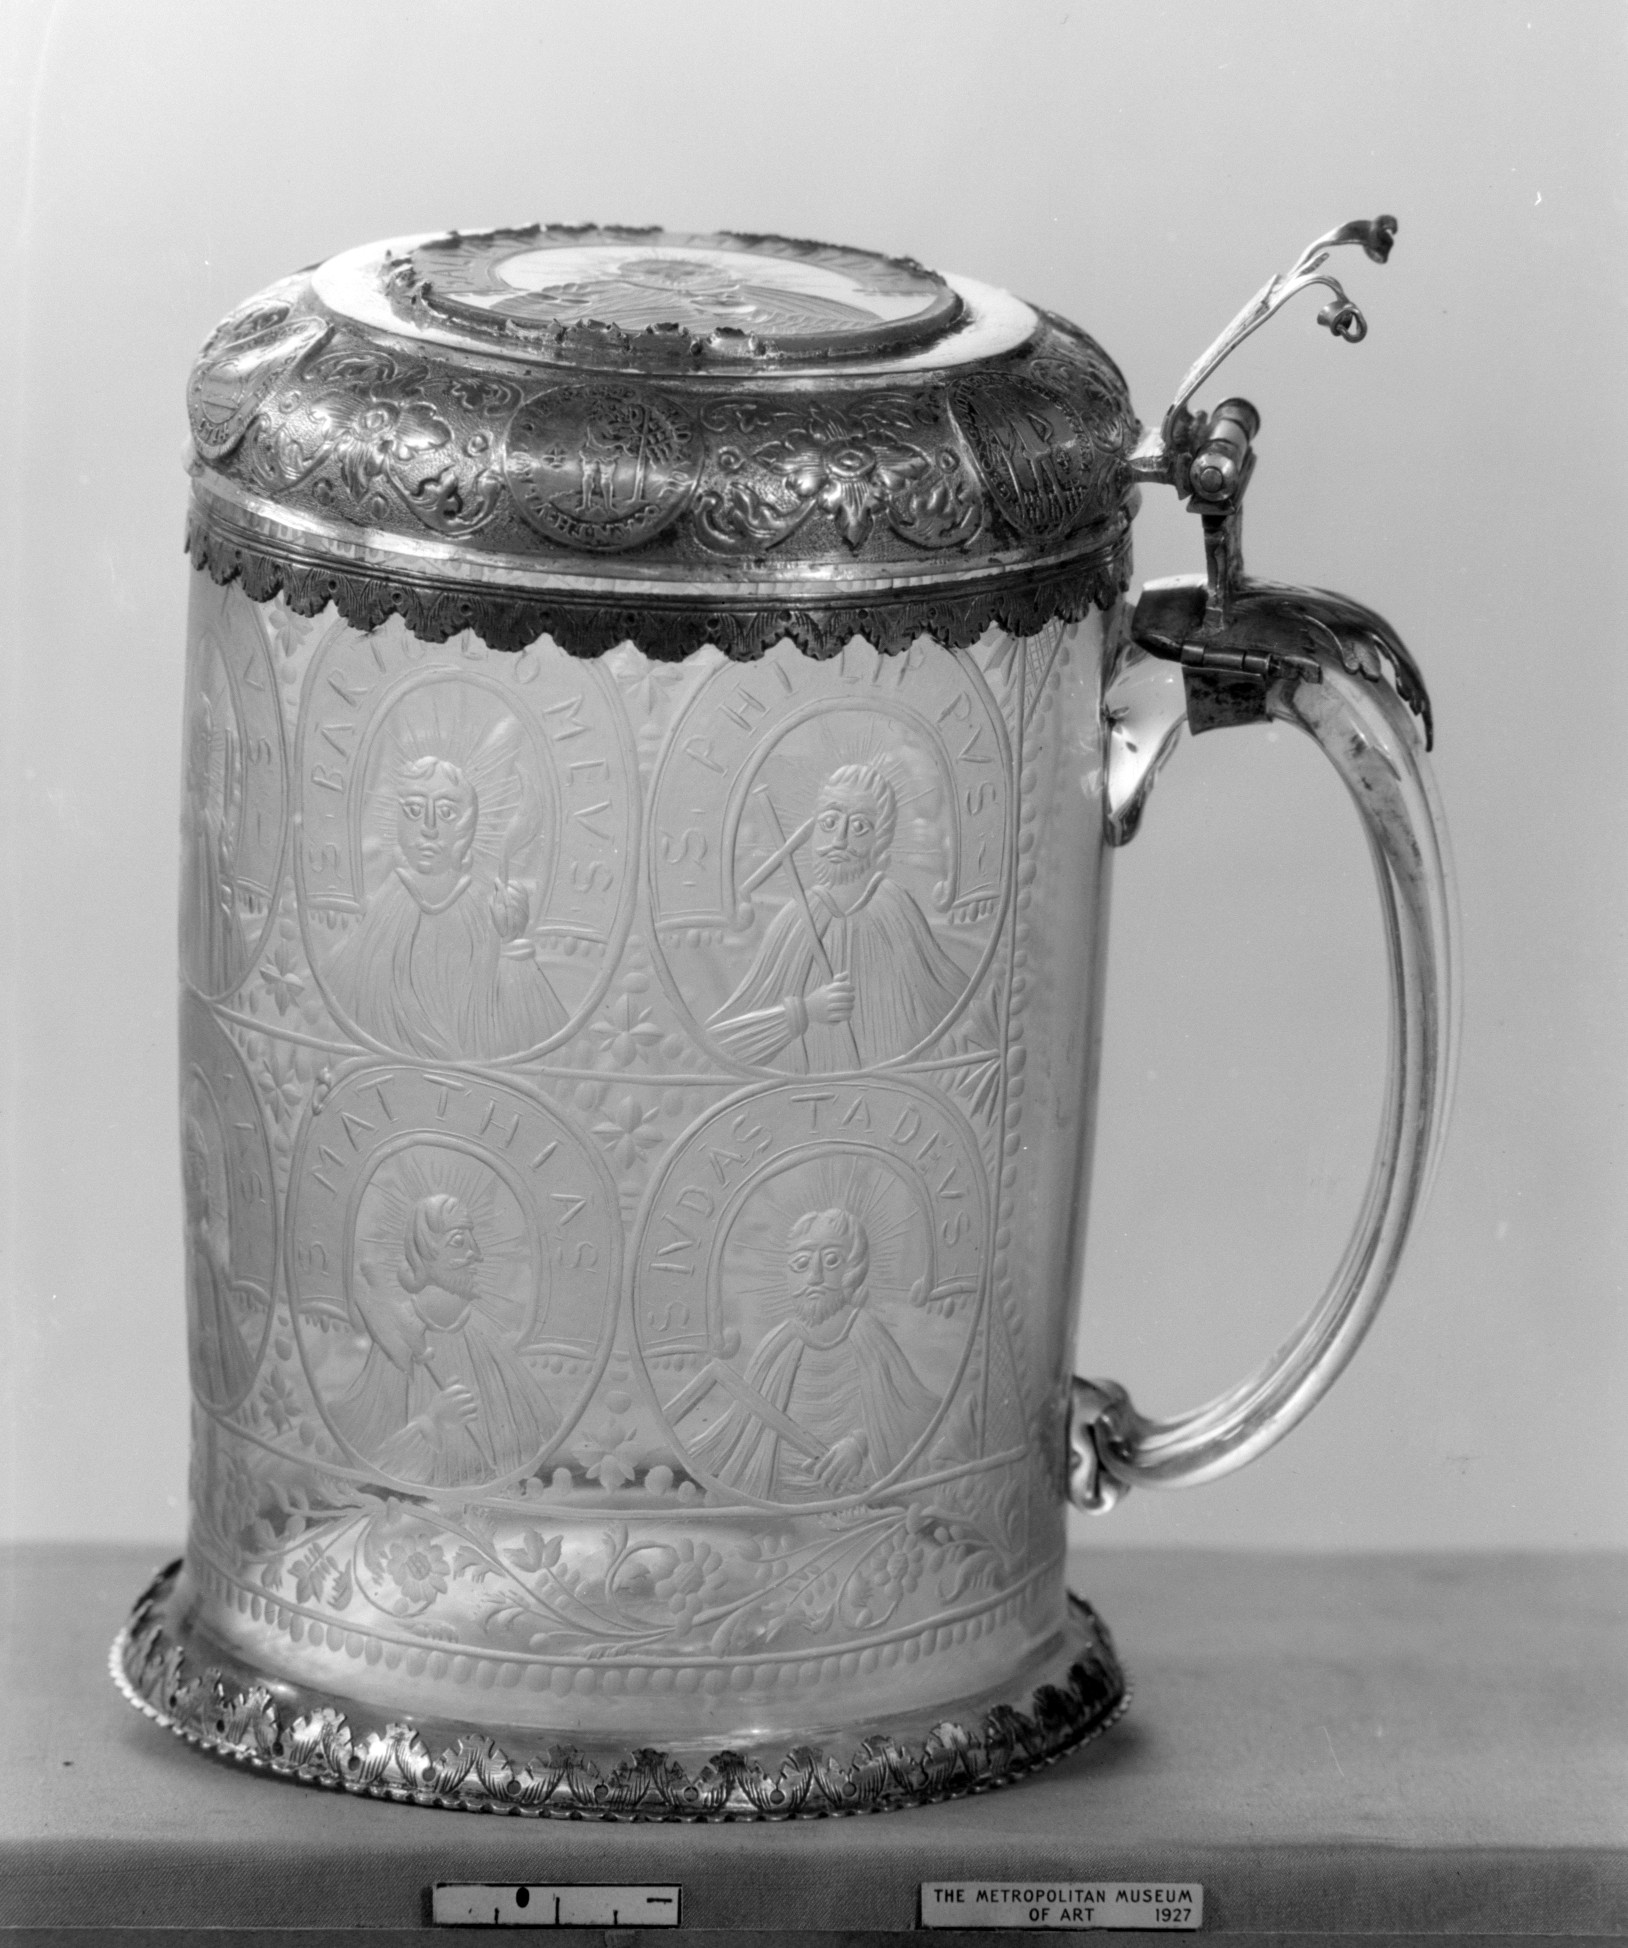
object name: tankard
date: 1720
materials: glass, silver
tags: men,cross